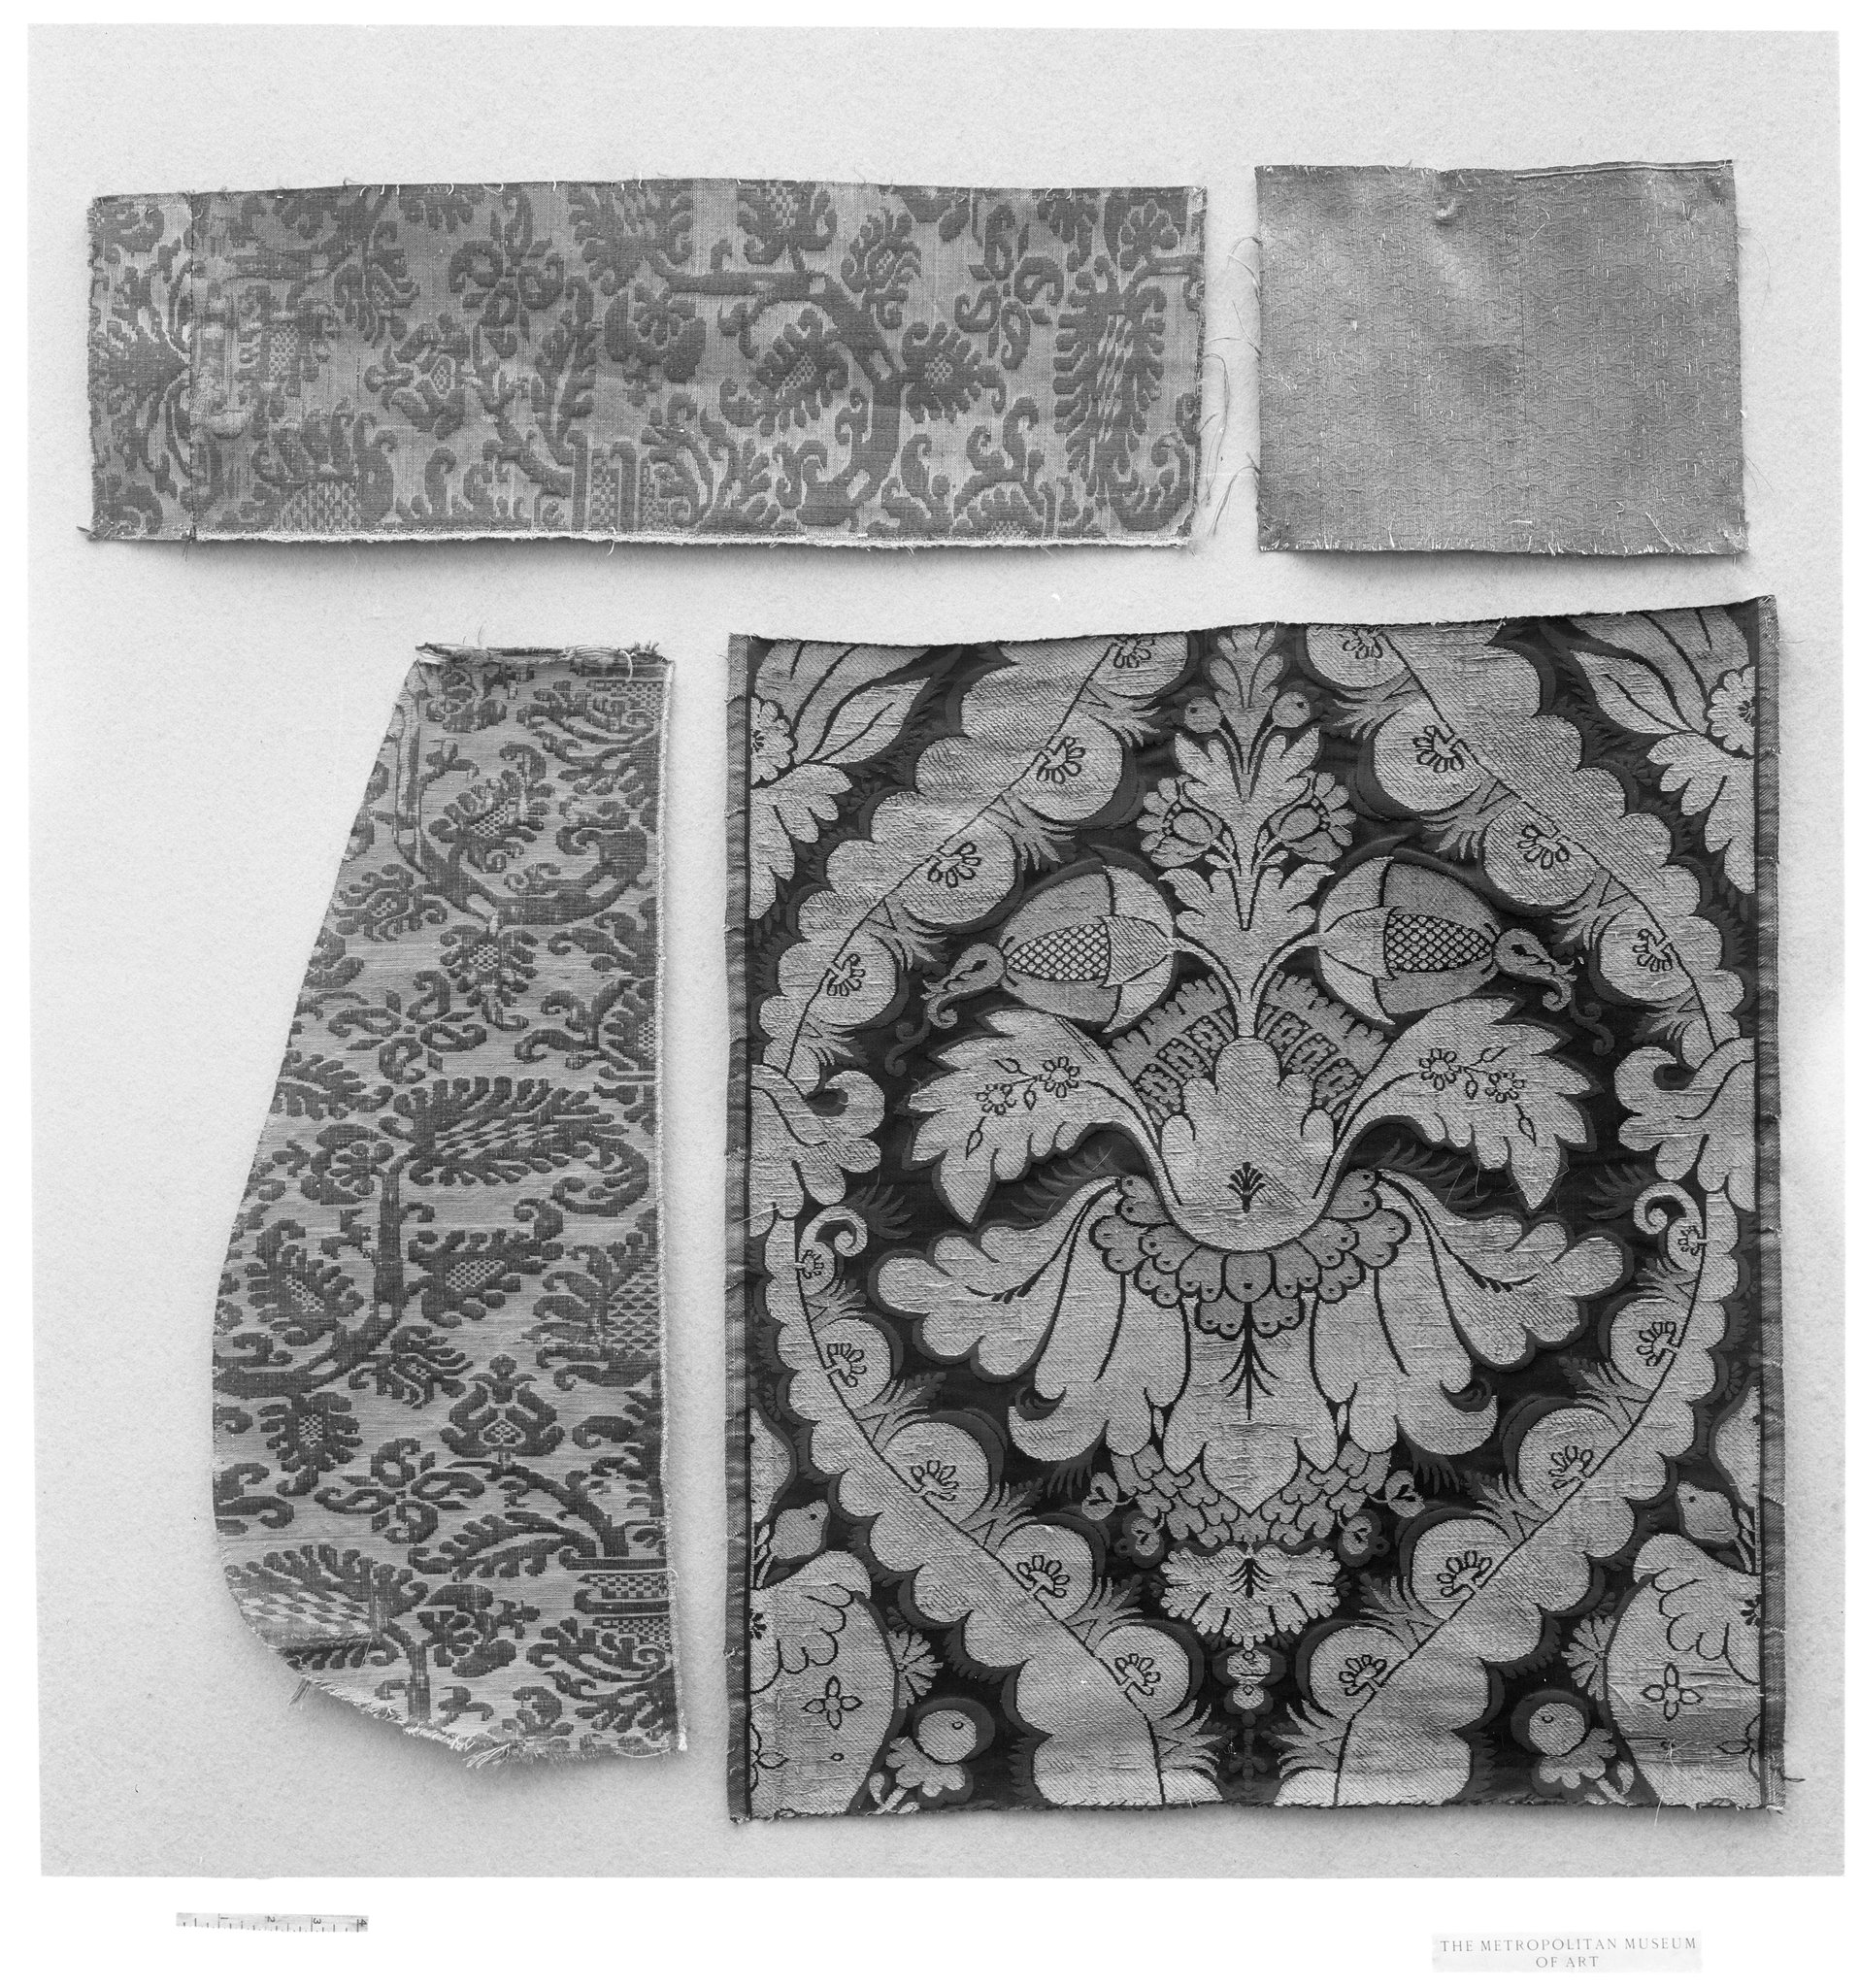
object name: piece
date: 1695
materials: metal thread, silk